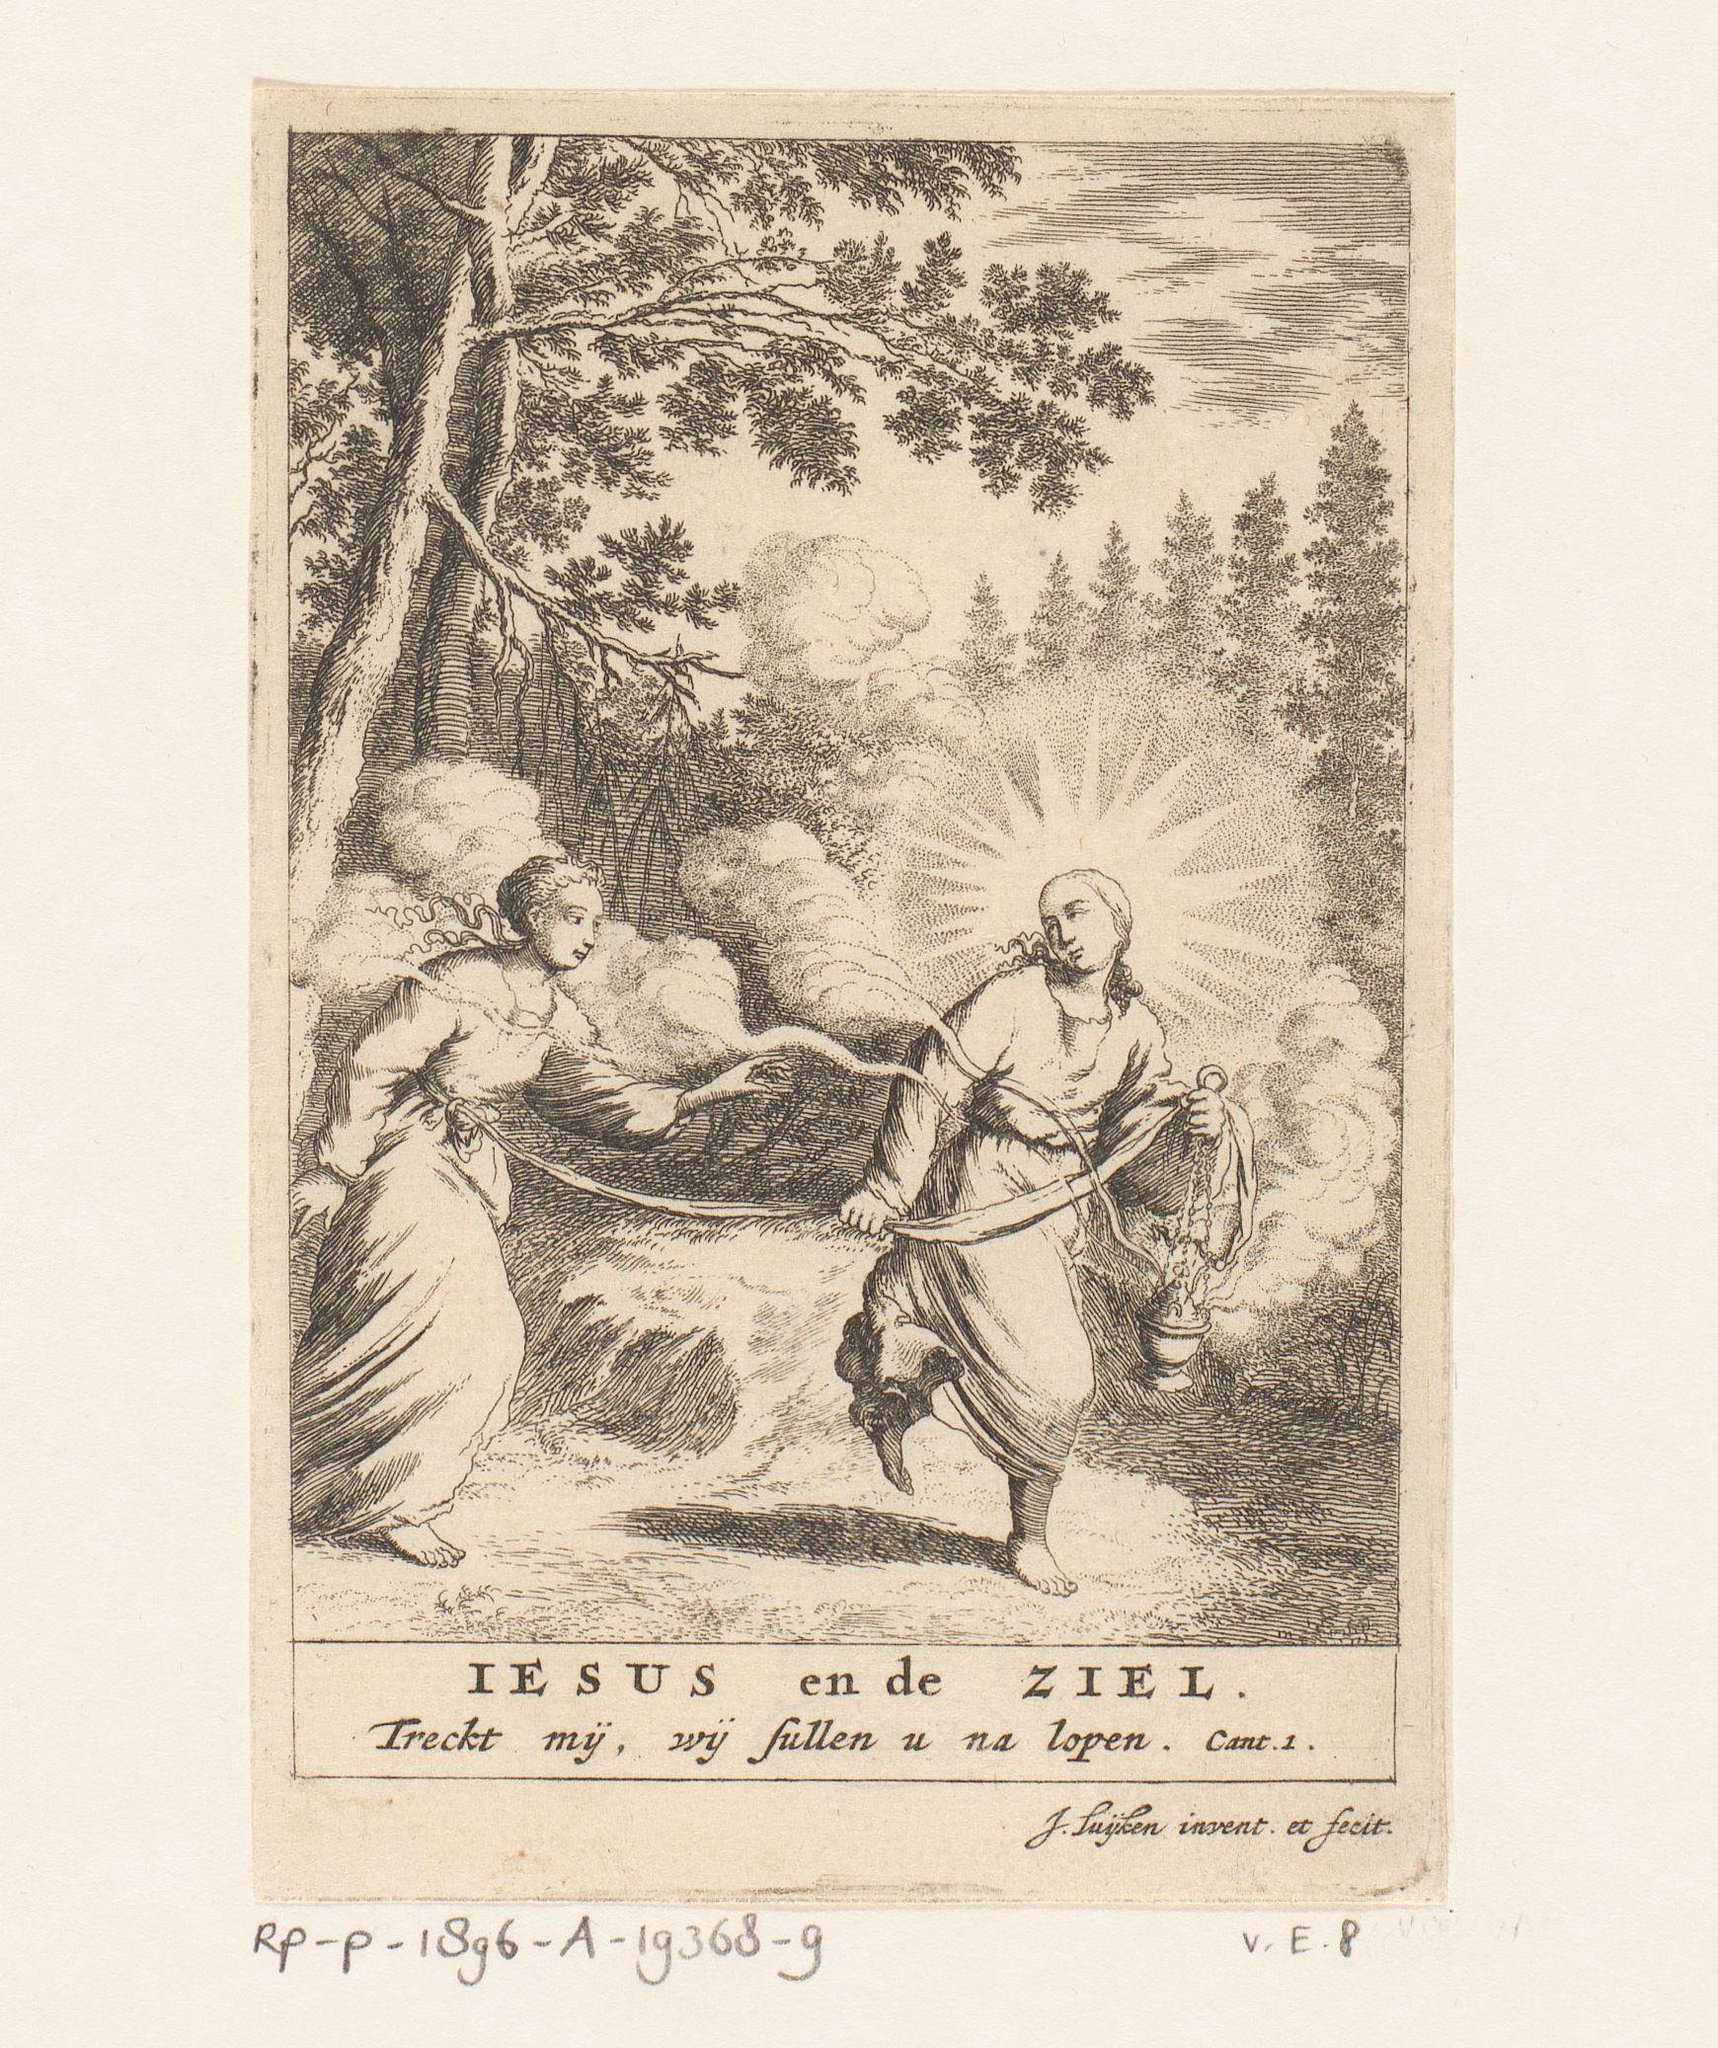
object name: titelblad, titelpagina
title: Titelpagina voor: J. Luyken, Jezus en de Ziel, 1678-1687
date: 1678-1687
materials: paper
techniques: etching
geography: amsterdam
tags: christ as youth, the soul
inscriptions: collector's mark: Lugt 2228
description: Titelpagina voor: Luyken, Jan. Jezus en de Ziel, 3 delen. Amsterdam: Pieter Arentsz II, 1678-1687.